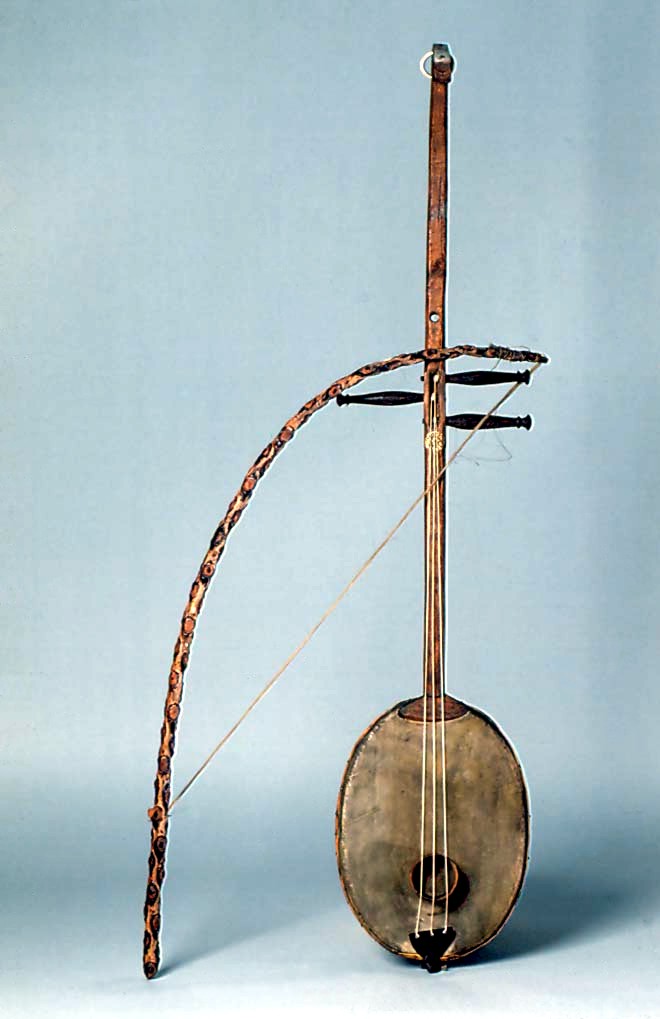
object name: tarawangsa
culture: javanese, sunda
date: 1801-1900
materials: metal, mother of pearl, parchment, silk, wood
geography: indonesia